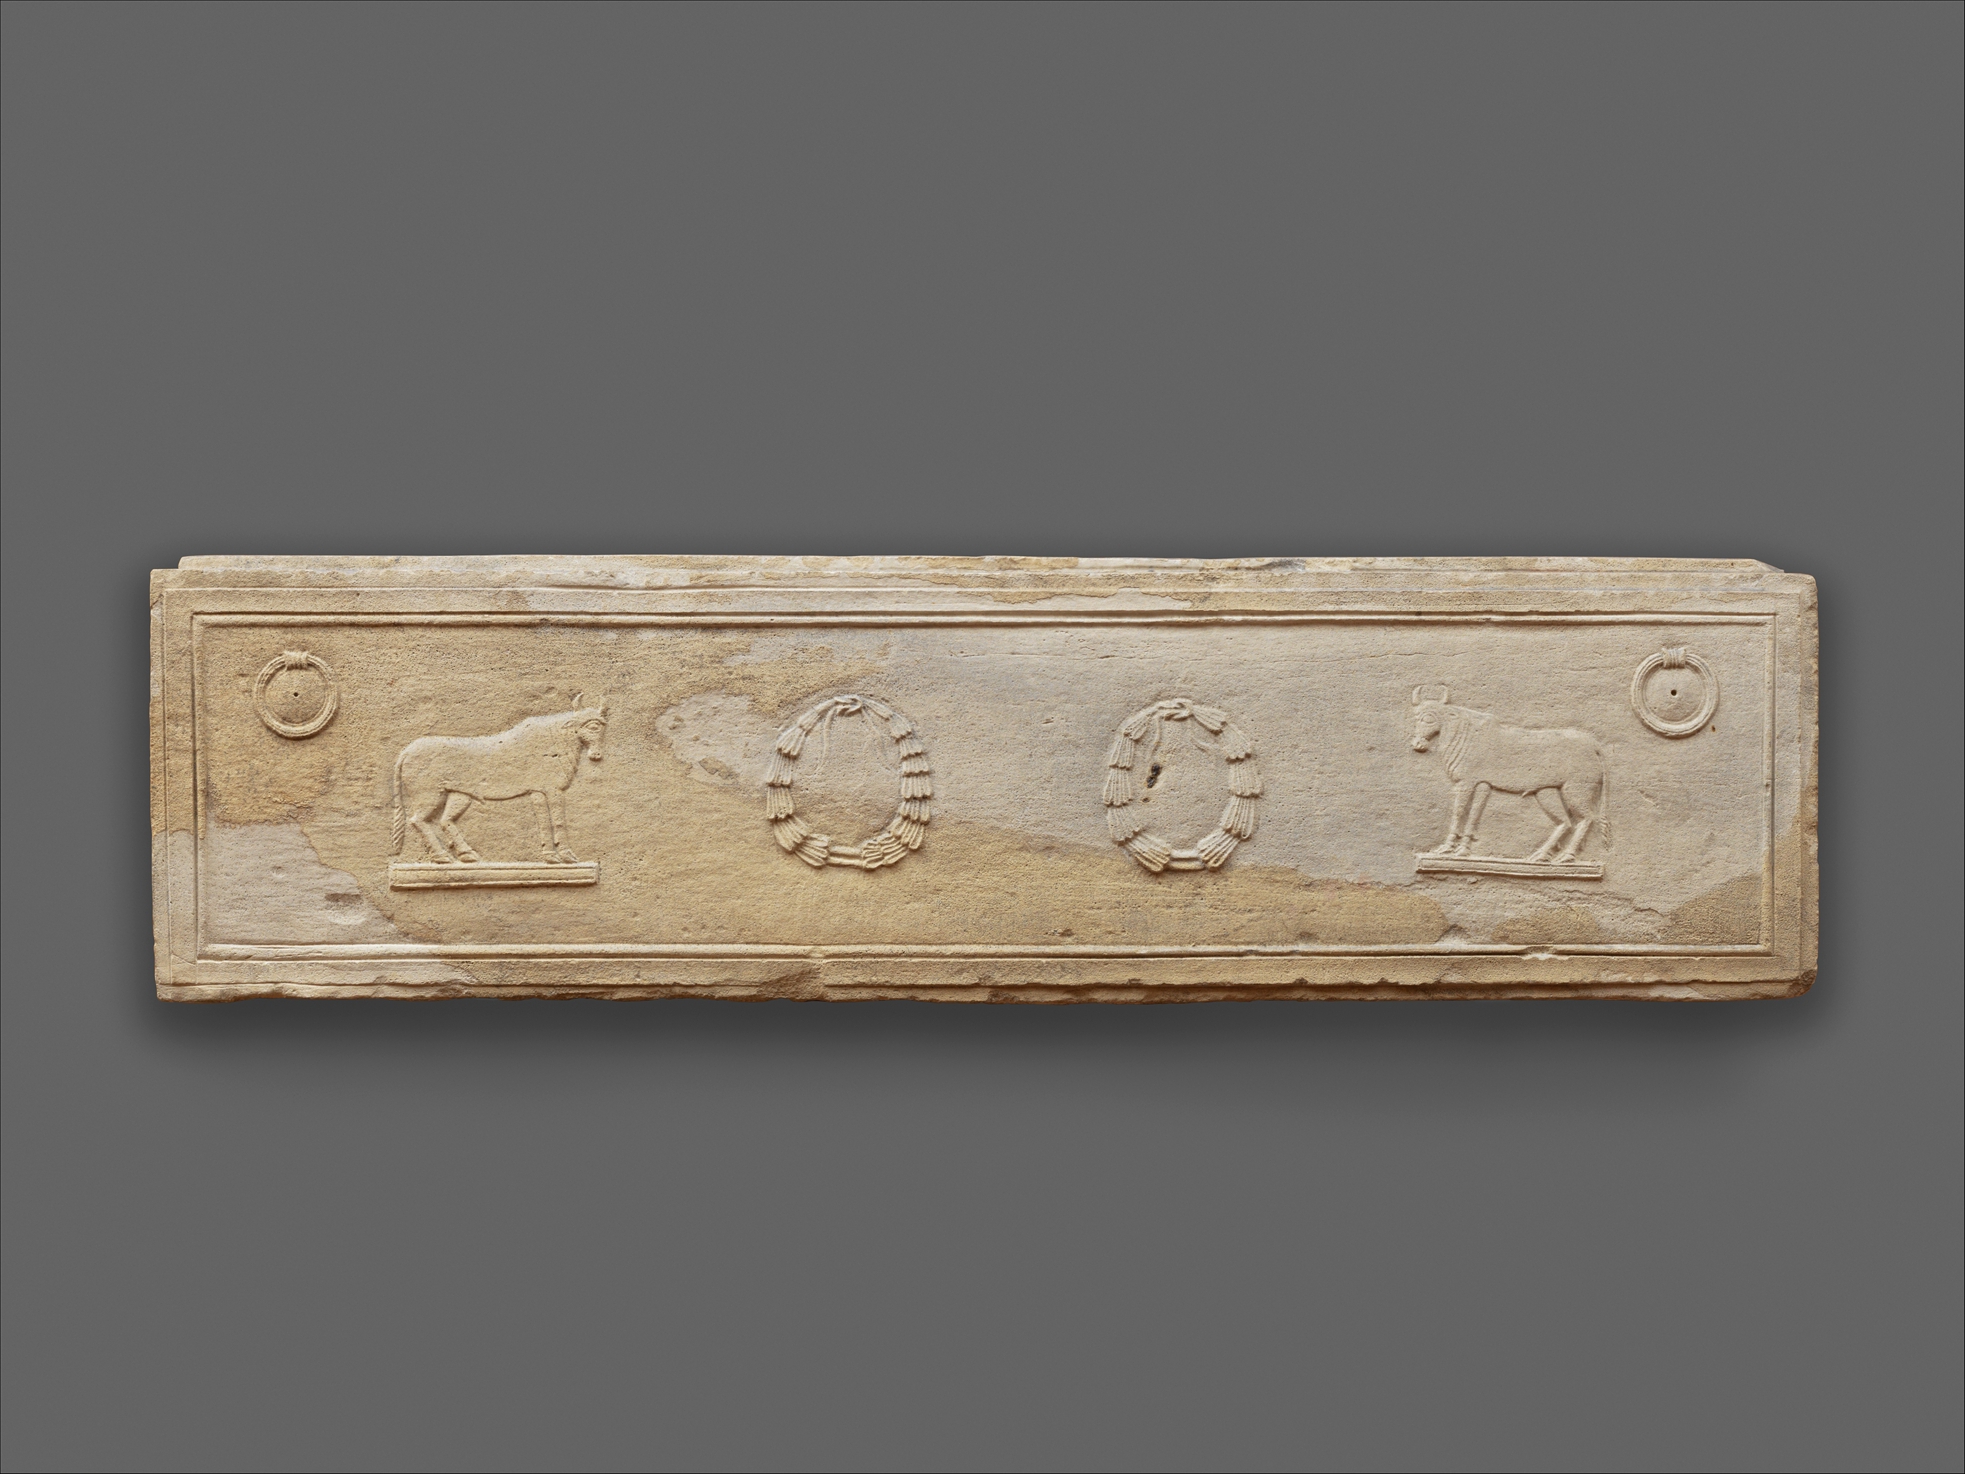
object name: sarcophagus fragment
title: Limestone fragment of a sarcophagus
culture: cypriot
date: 300-201 BCE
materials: limestone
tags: bulls,wreaths,sarcophagus